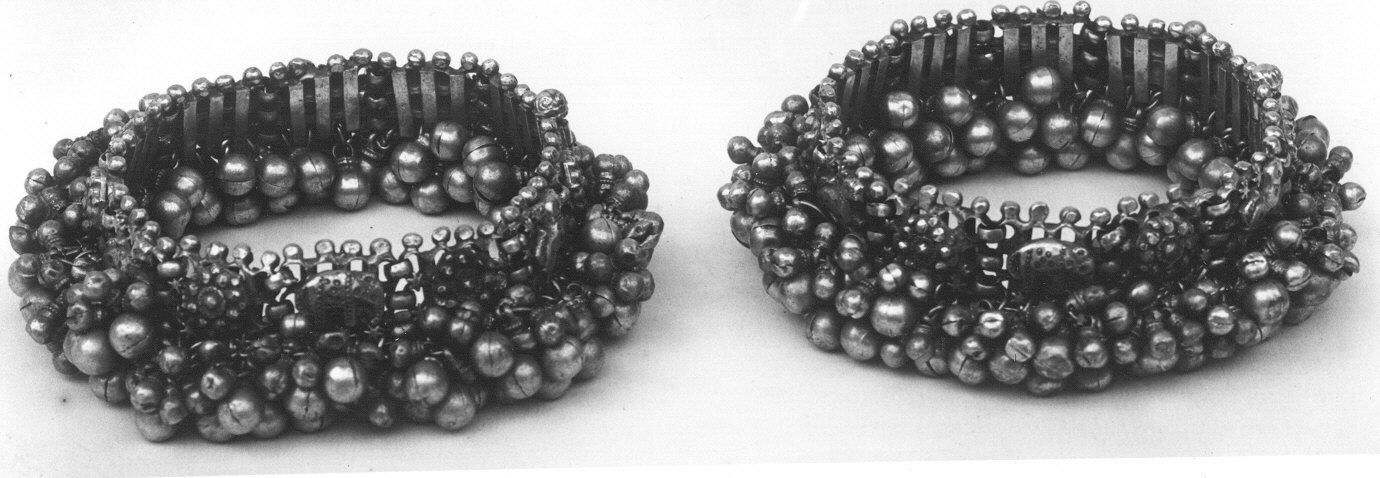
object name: anklet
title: Anklet, One of a Pair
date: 1801-1900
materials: silver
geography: central india